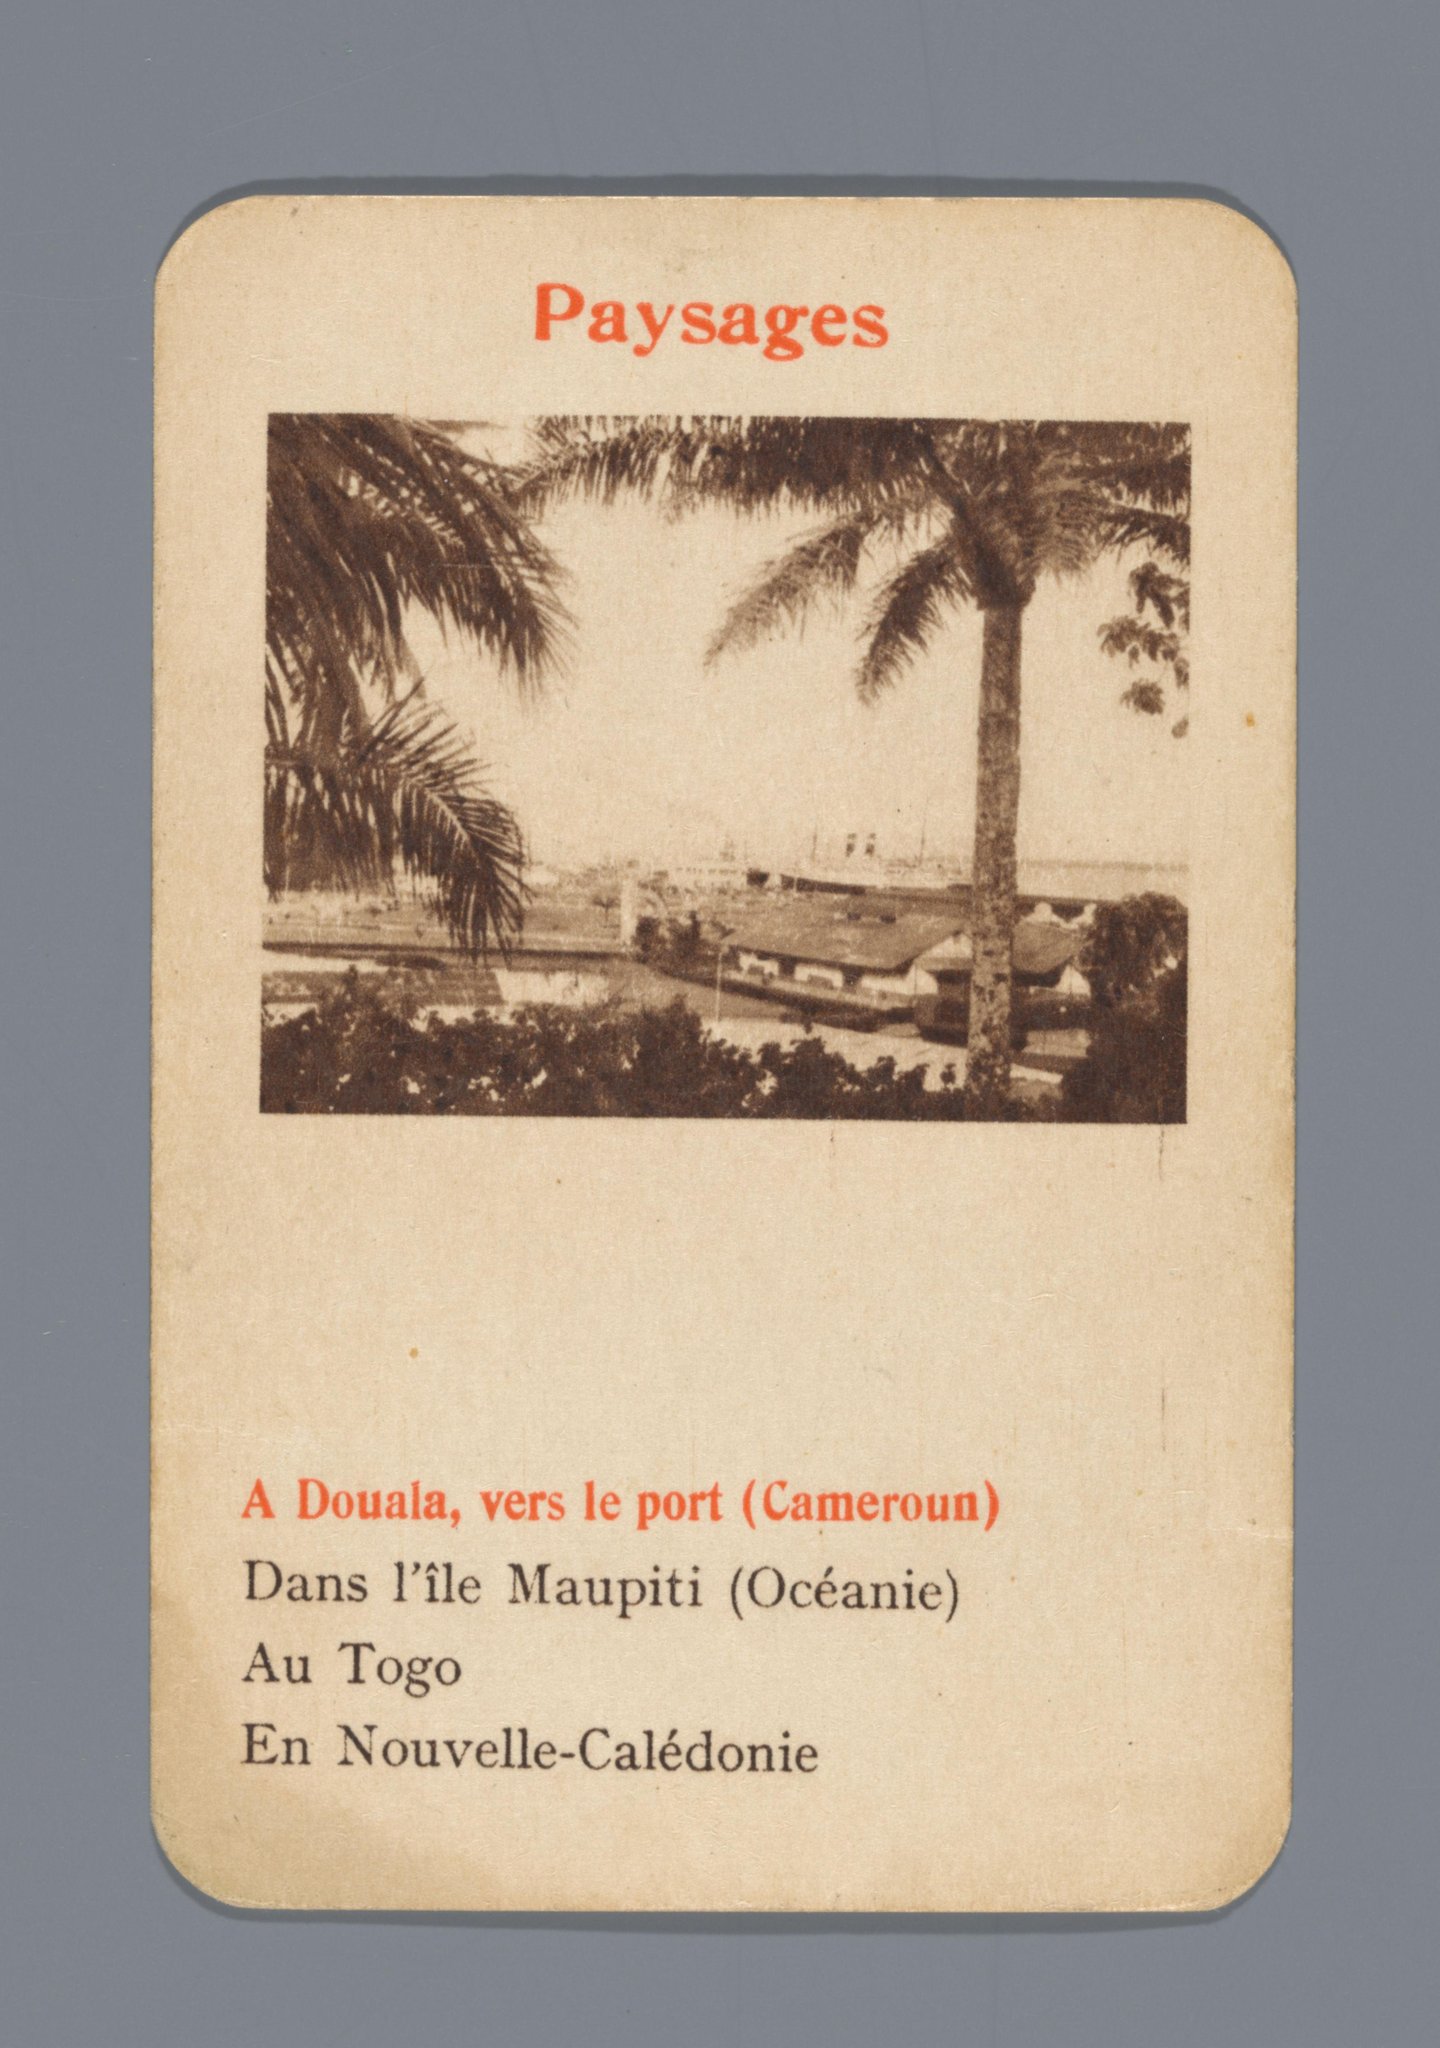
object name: card game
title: A Douala, vers le port (Cameroun)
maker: Anonymous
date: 1900-1920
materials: cardboard, paper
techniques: rotogravure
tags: harbour, card games